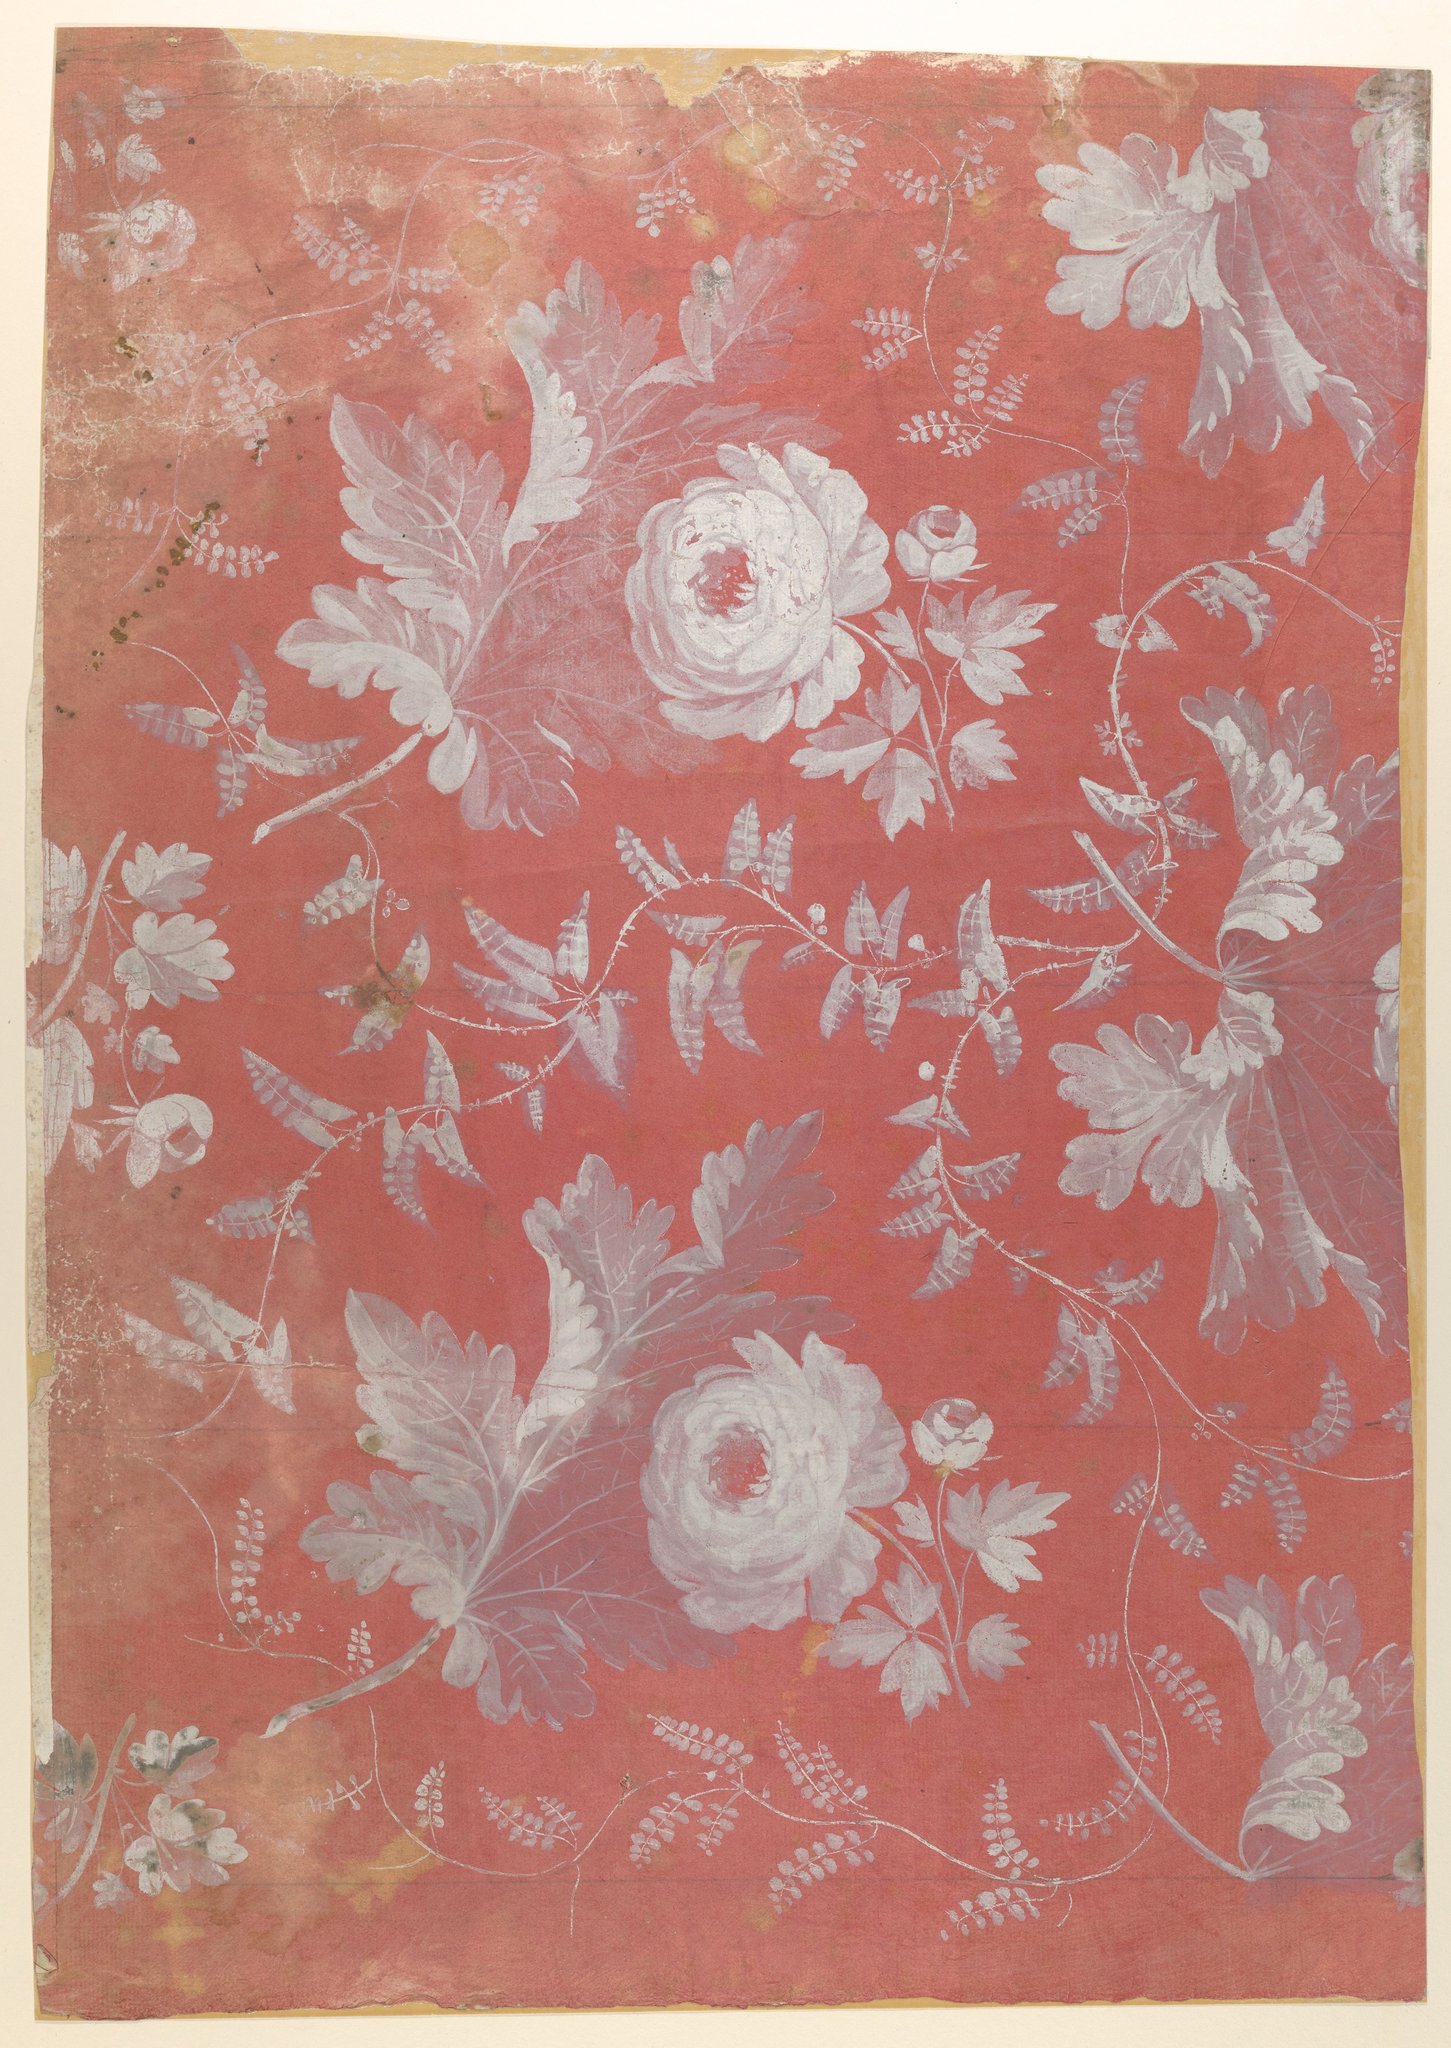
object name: drawing collection ornament architecture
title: Design for Patterned Silk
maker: jean françois bony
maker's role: artist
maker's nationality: french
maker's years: 1760-1825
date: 1780-1825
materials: gouache, paper, watercolor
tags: roses,leaves